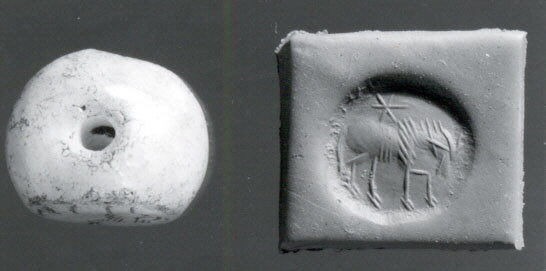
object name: stamp seal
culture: sasanian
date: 201-700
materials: stone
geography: iran or mesopotamia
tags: animals